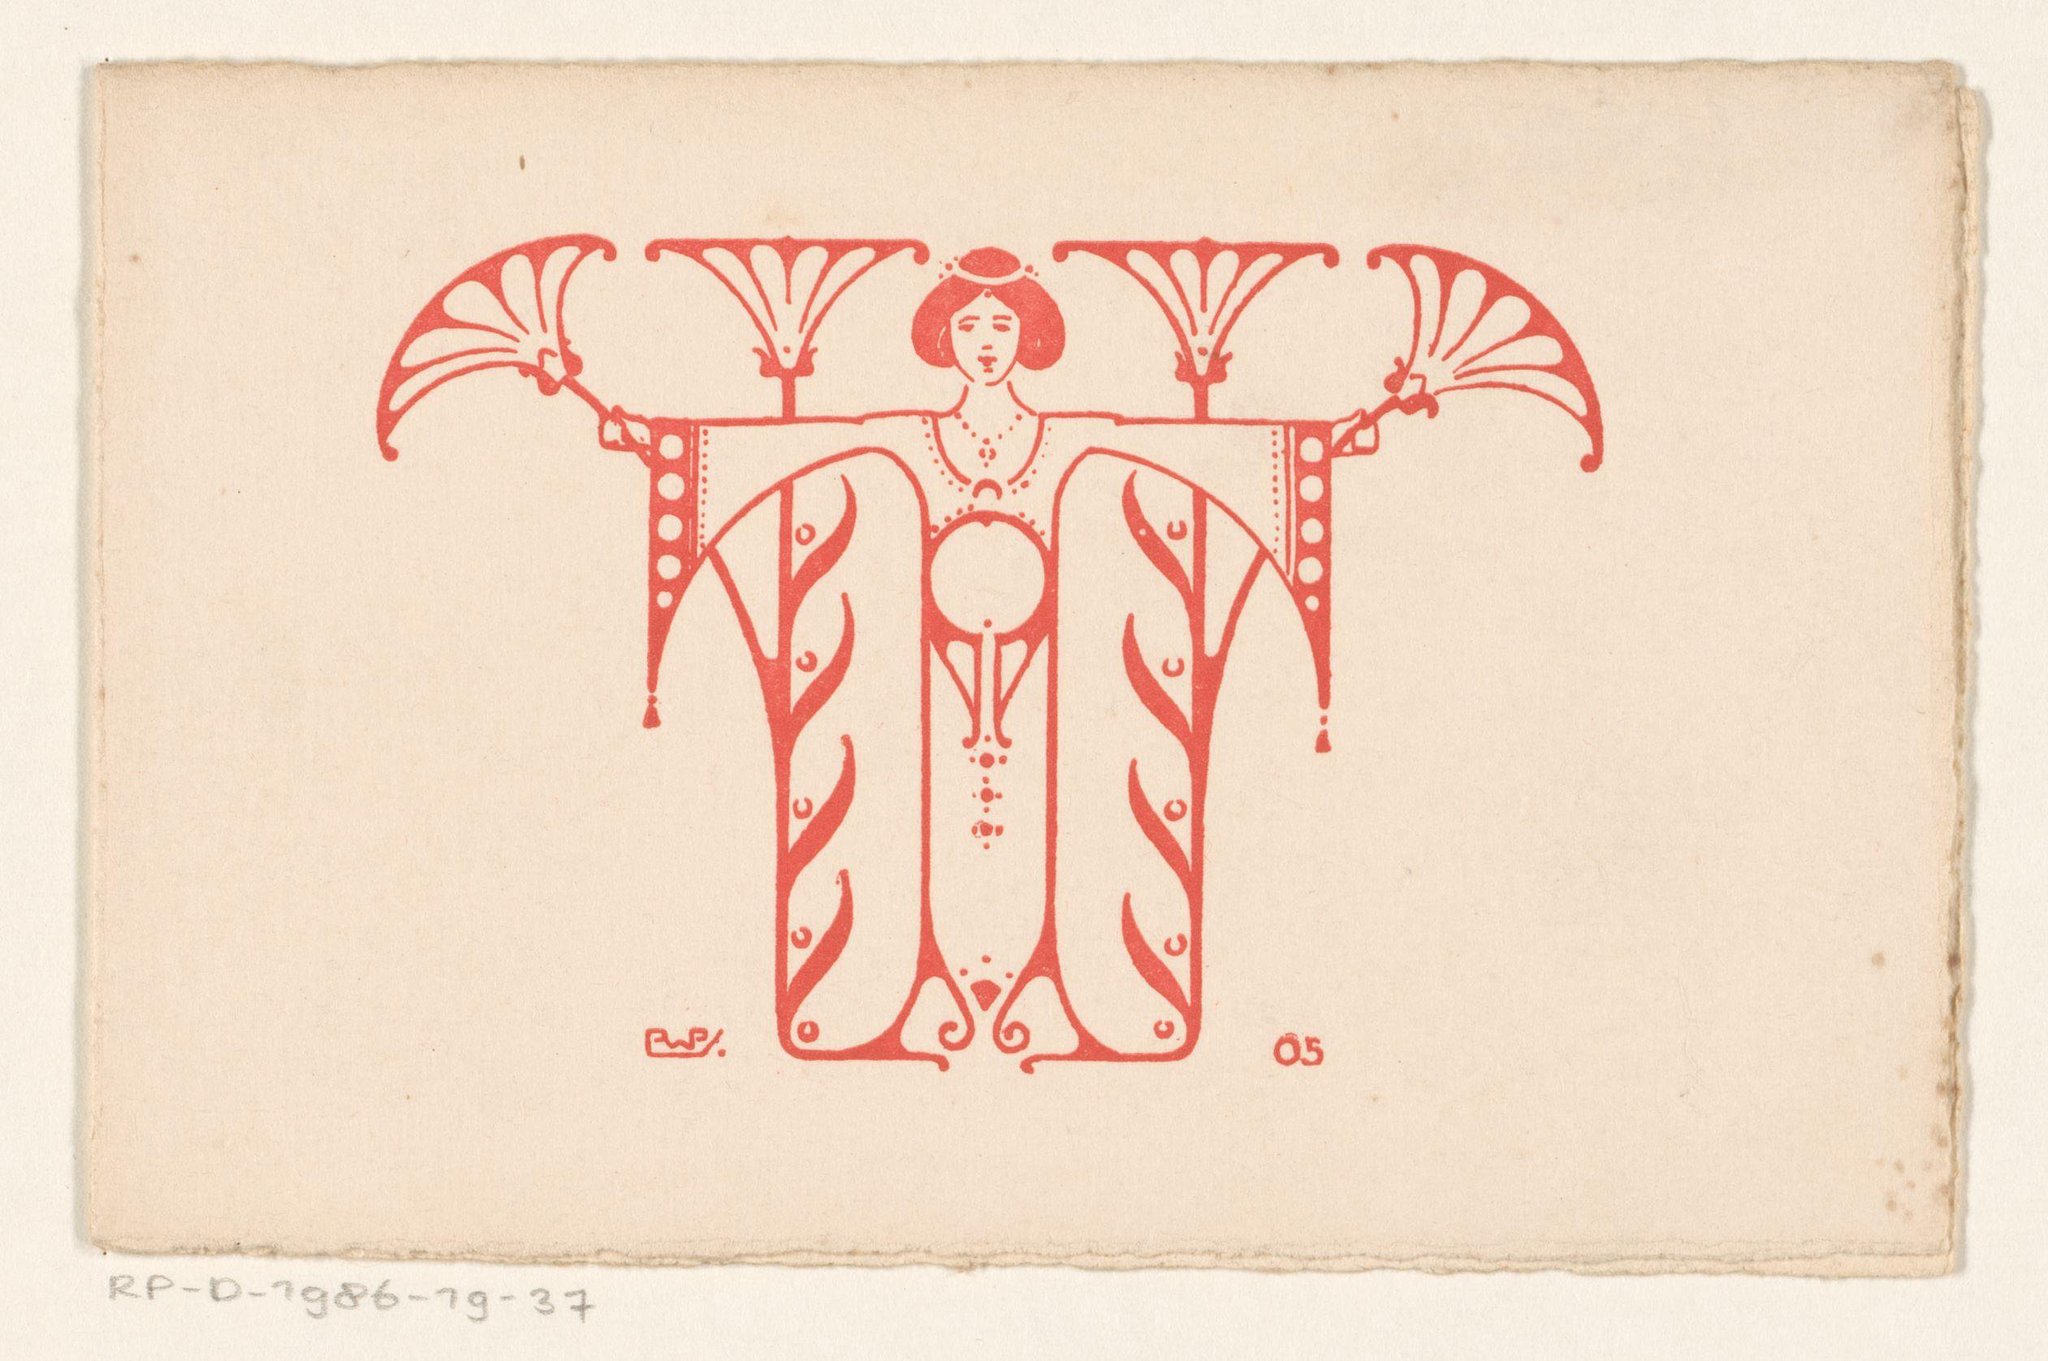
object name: advertising card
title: Reclamekaart voor lessen in Versieringskunst door R.W.P. de Vries Jr.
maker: reinier willem petrus de vries (1874-1953)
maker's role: draughtsman, print maker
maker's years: 1874-1953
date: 1905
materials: paper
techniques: relief print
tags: arm stretched sidewards - aa - both arms or hands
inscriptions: collector's mark: ‘R:MVS.’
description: Vrouw in een lange japon met uitgestrekte armen. In haar handen houdt zij een decoratief object, mogelijk een waaier, vast.